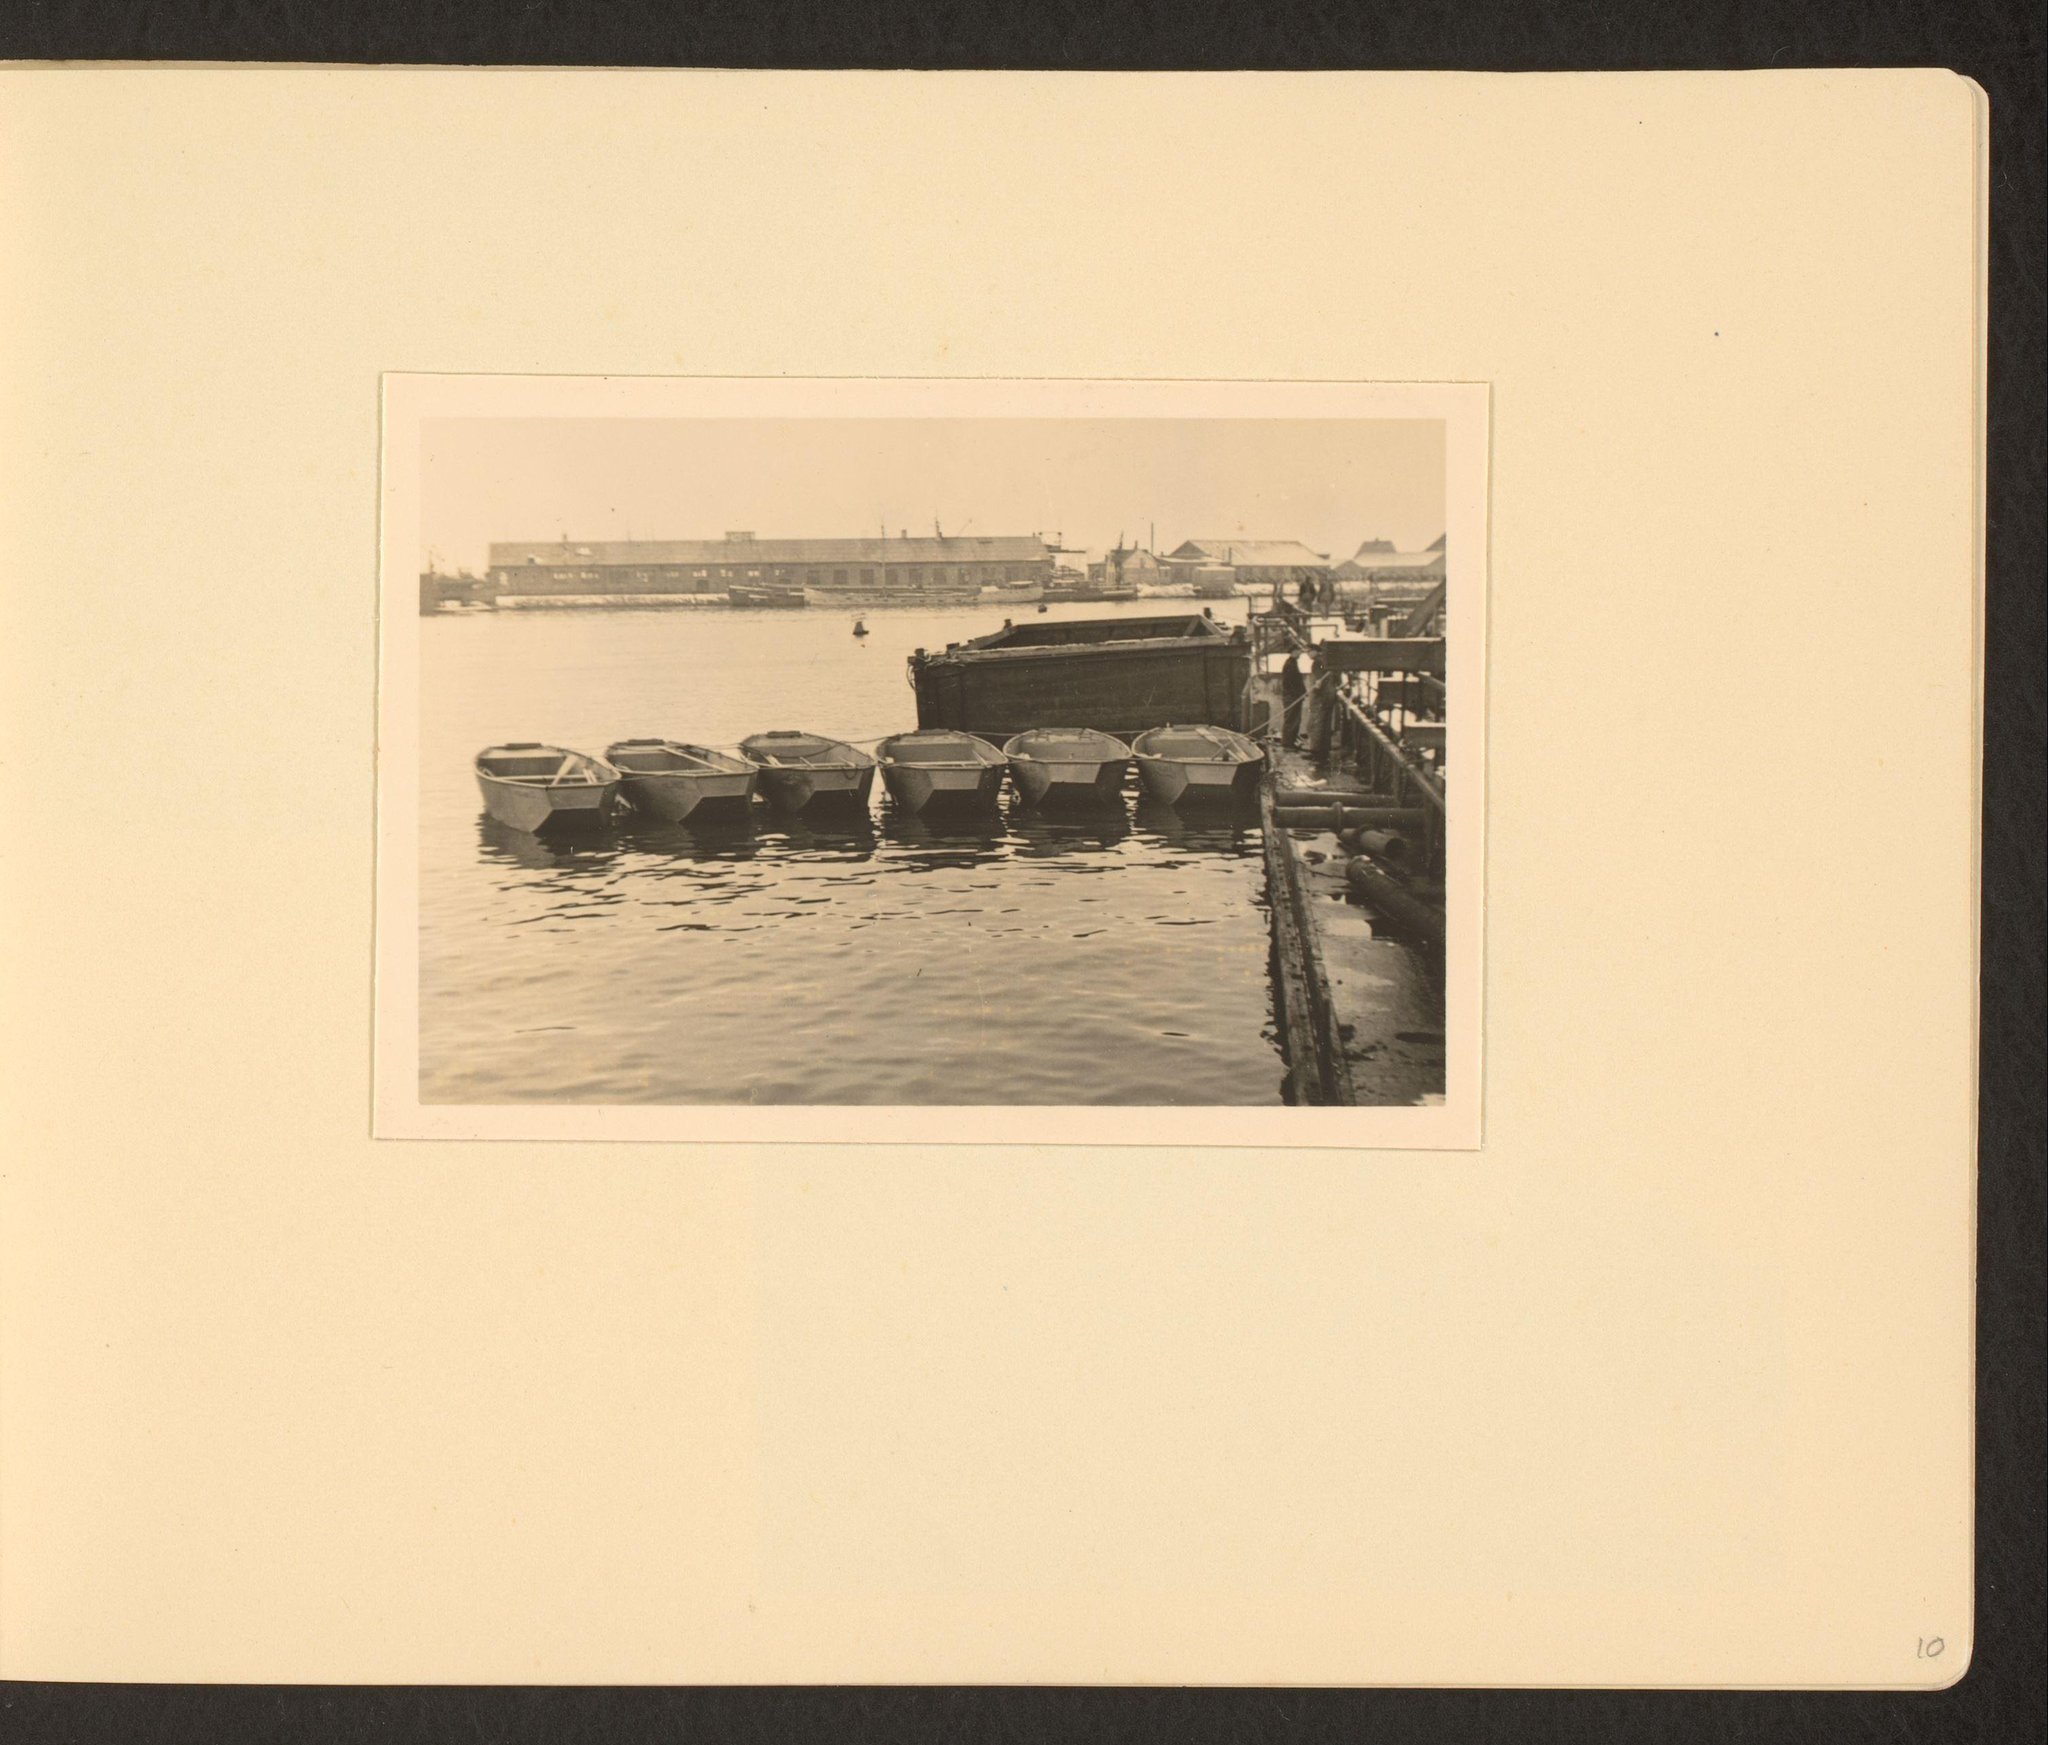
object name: photograph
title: Zes sloepen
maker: Anonymous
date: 1902-1953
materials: paper, photographic support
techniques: gelatin silver print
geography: emden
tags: building a ship, ship under construction, pier, quay, wharf, steamship, motorship, north sea flood of 1953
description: Albumblad met een foto van zes van de metalen sloepen, gebouwd door Nordseewerke Emden, in het water. Onderdeel van het fotoalbum 'Emden hilft Holland'.